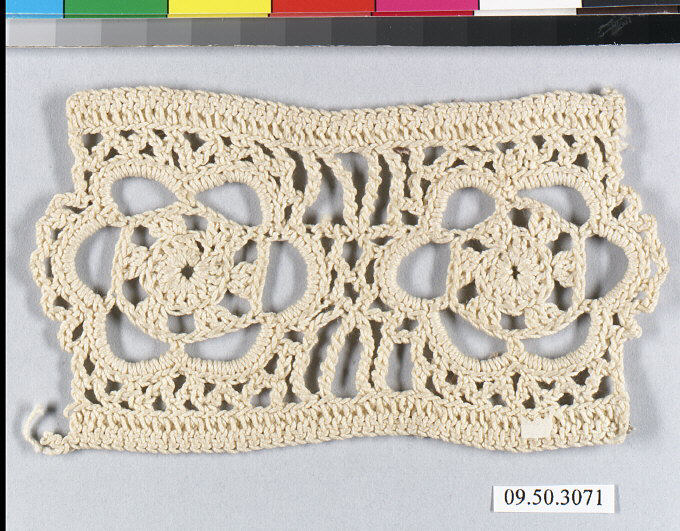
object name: sample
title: Crochet Work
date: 1801-1900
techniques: crochet